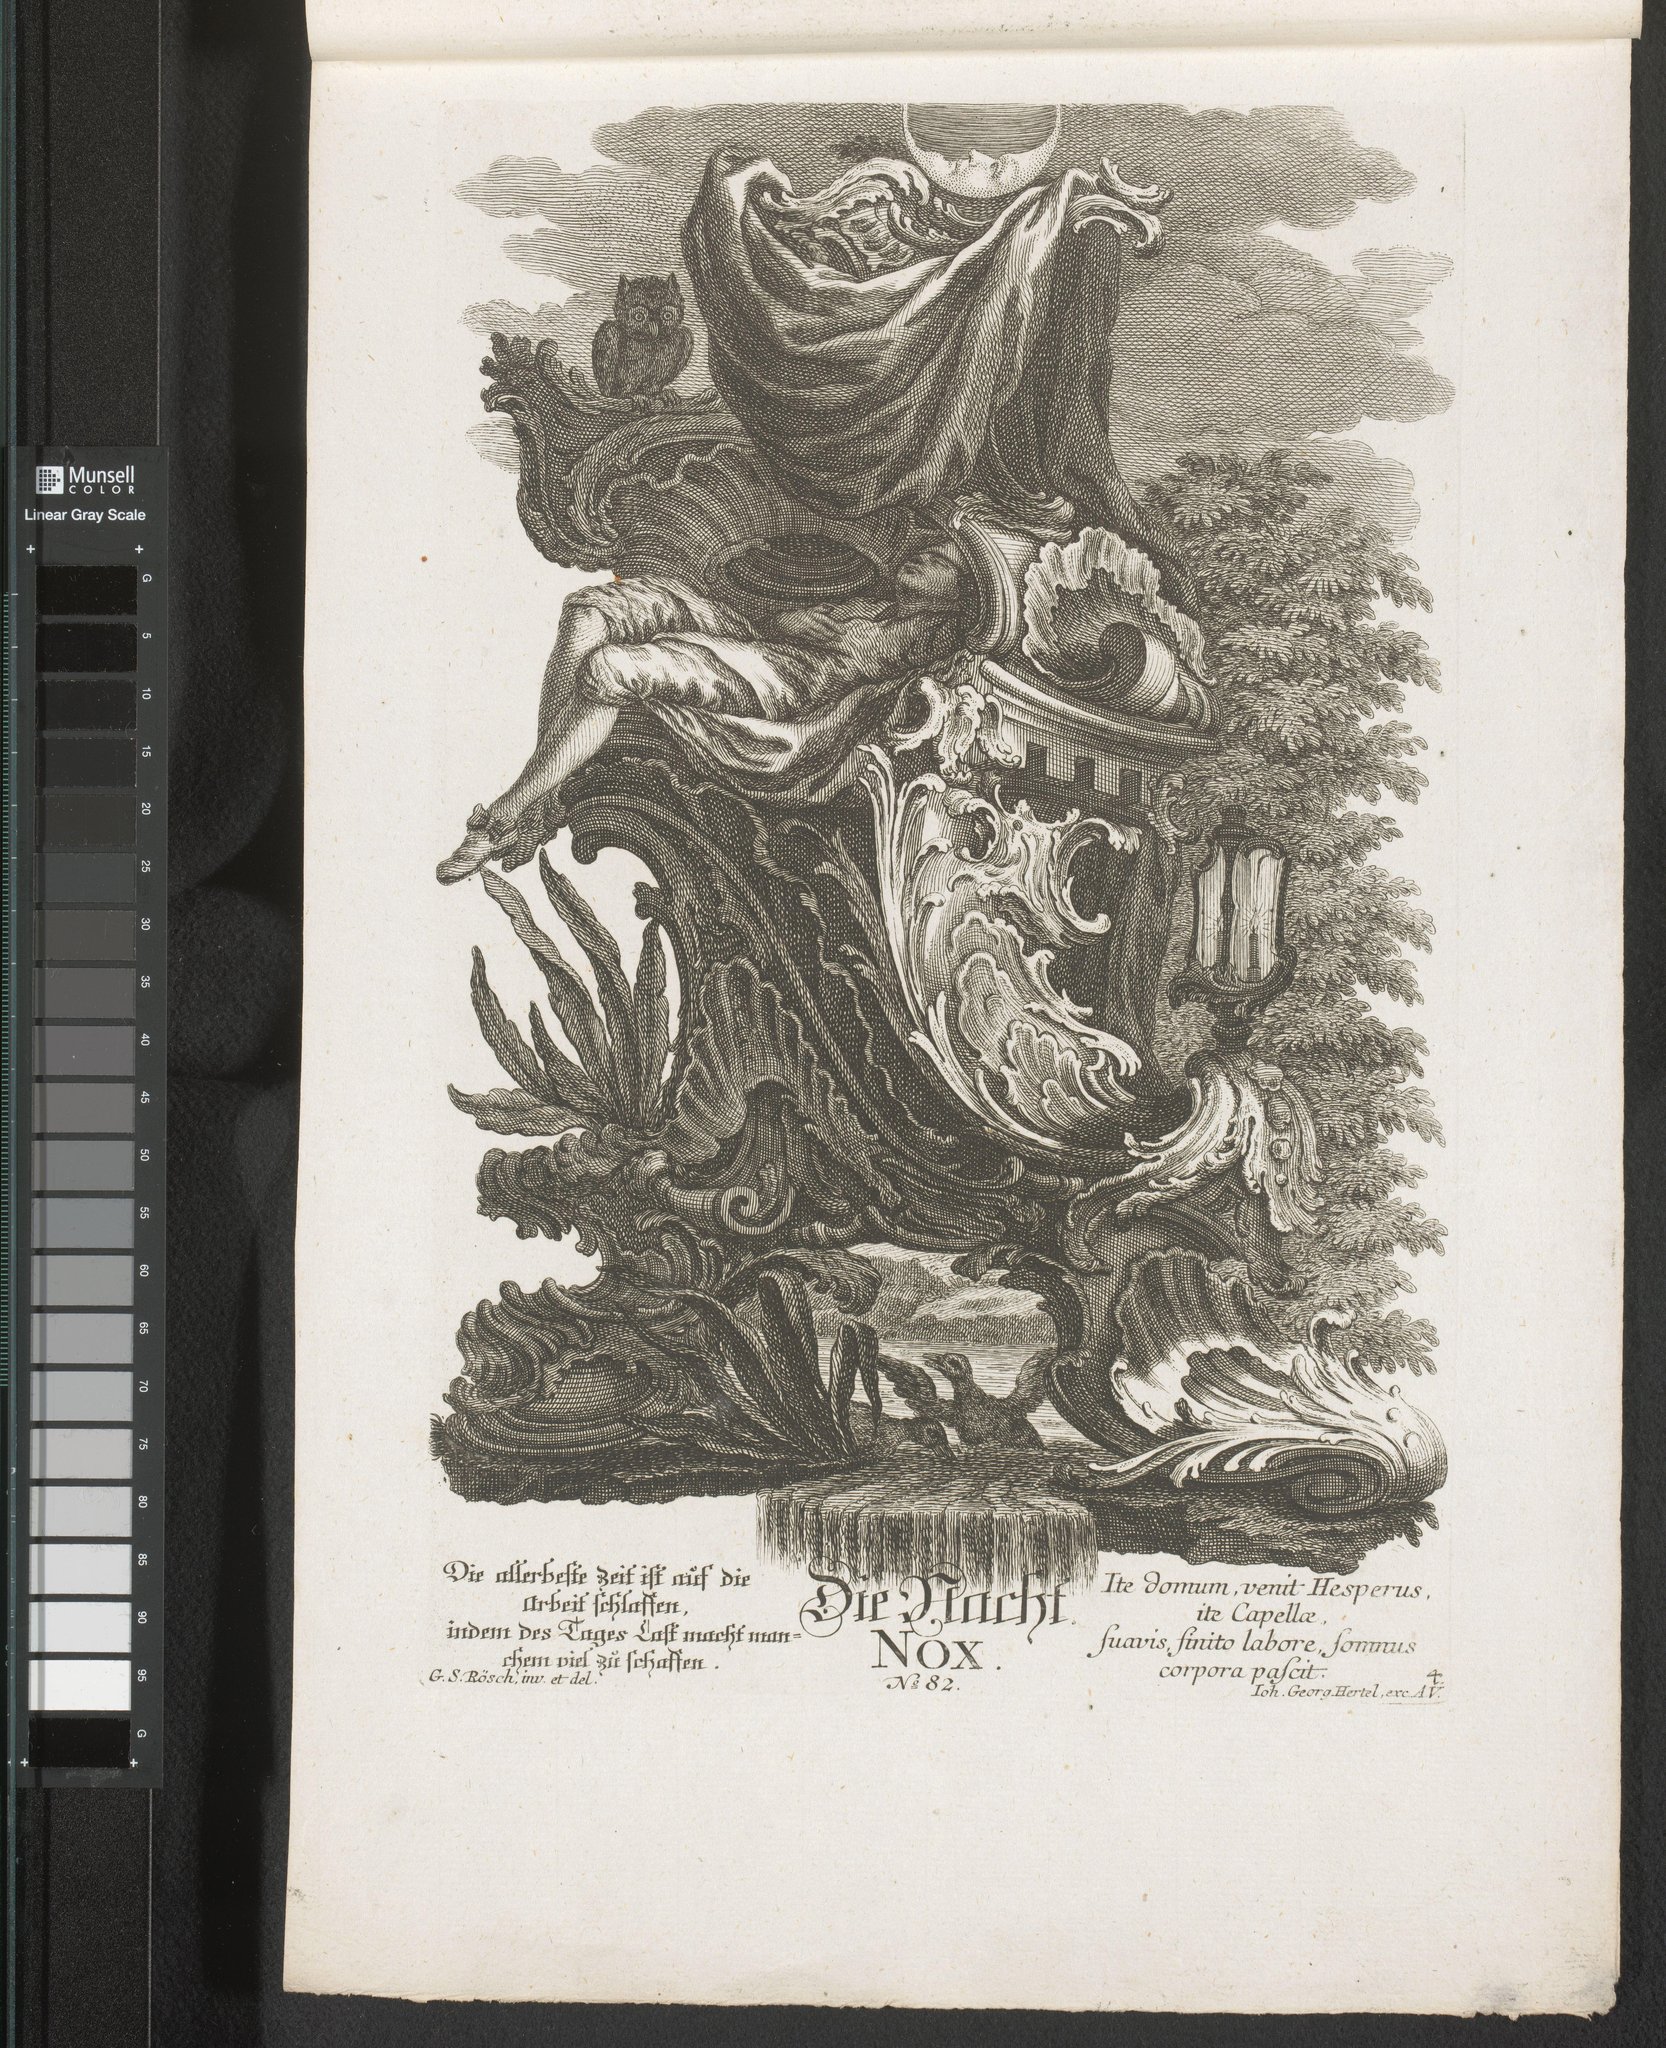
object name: print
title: Isis en Juno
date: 1731-1775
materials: paper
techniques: engraving, etching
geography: augsburg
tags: specific aspects, allegorical aspects of juno; juno as patroness, isis, the mother-goddess - specific aspects, allegorical aspects of non-christian god or goddess, ornament ~ cartouche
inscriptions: collector's mark: Lugt 2228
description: Twee cartouches met busten van godinnen. Links Isis in een landschap met fruitboom en dieren, als godin van de vruchtbaarheid met meerdere borsten op haar lichaam. Rechts Juno in een landschap met een tempel en een pauw. Uitgeversnummer 56.